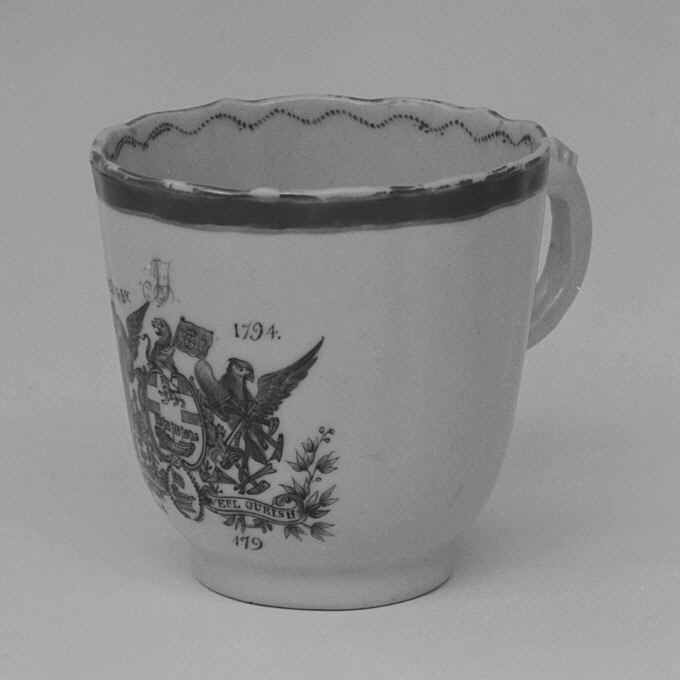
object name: cup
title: Cup (part of a service)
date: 1795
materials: hard paste porcelain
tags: eagles,coat of arms